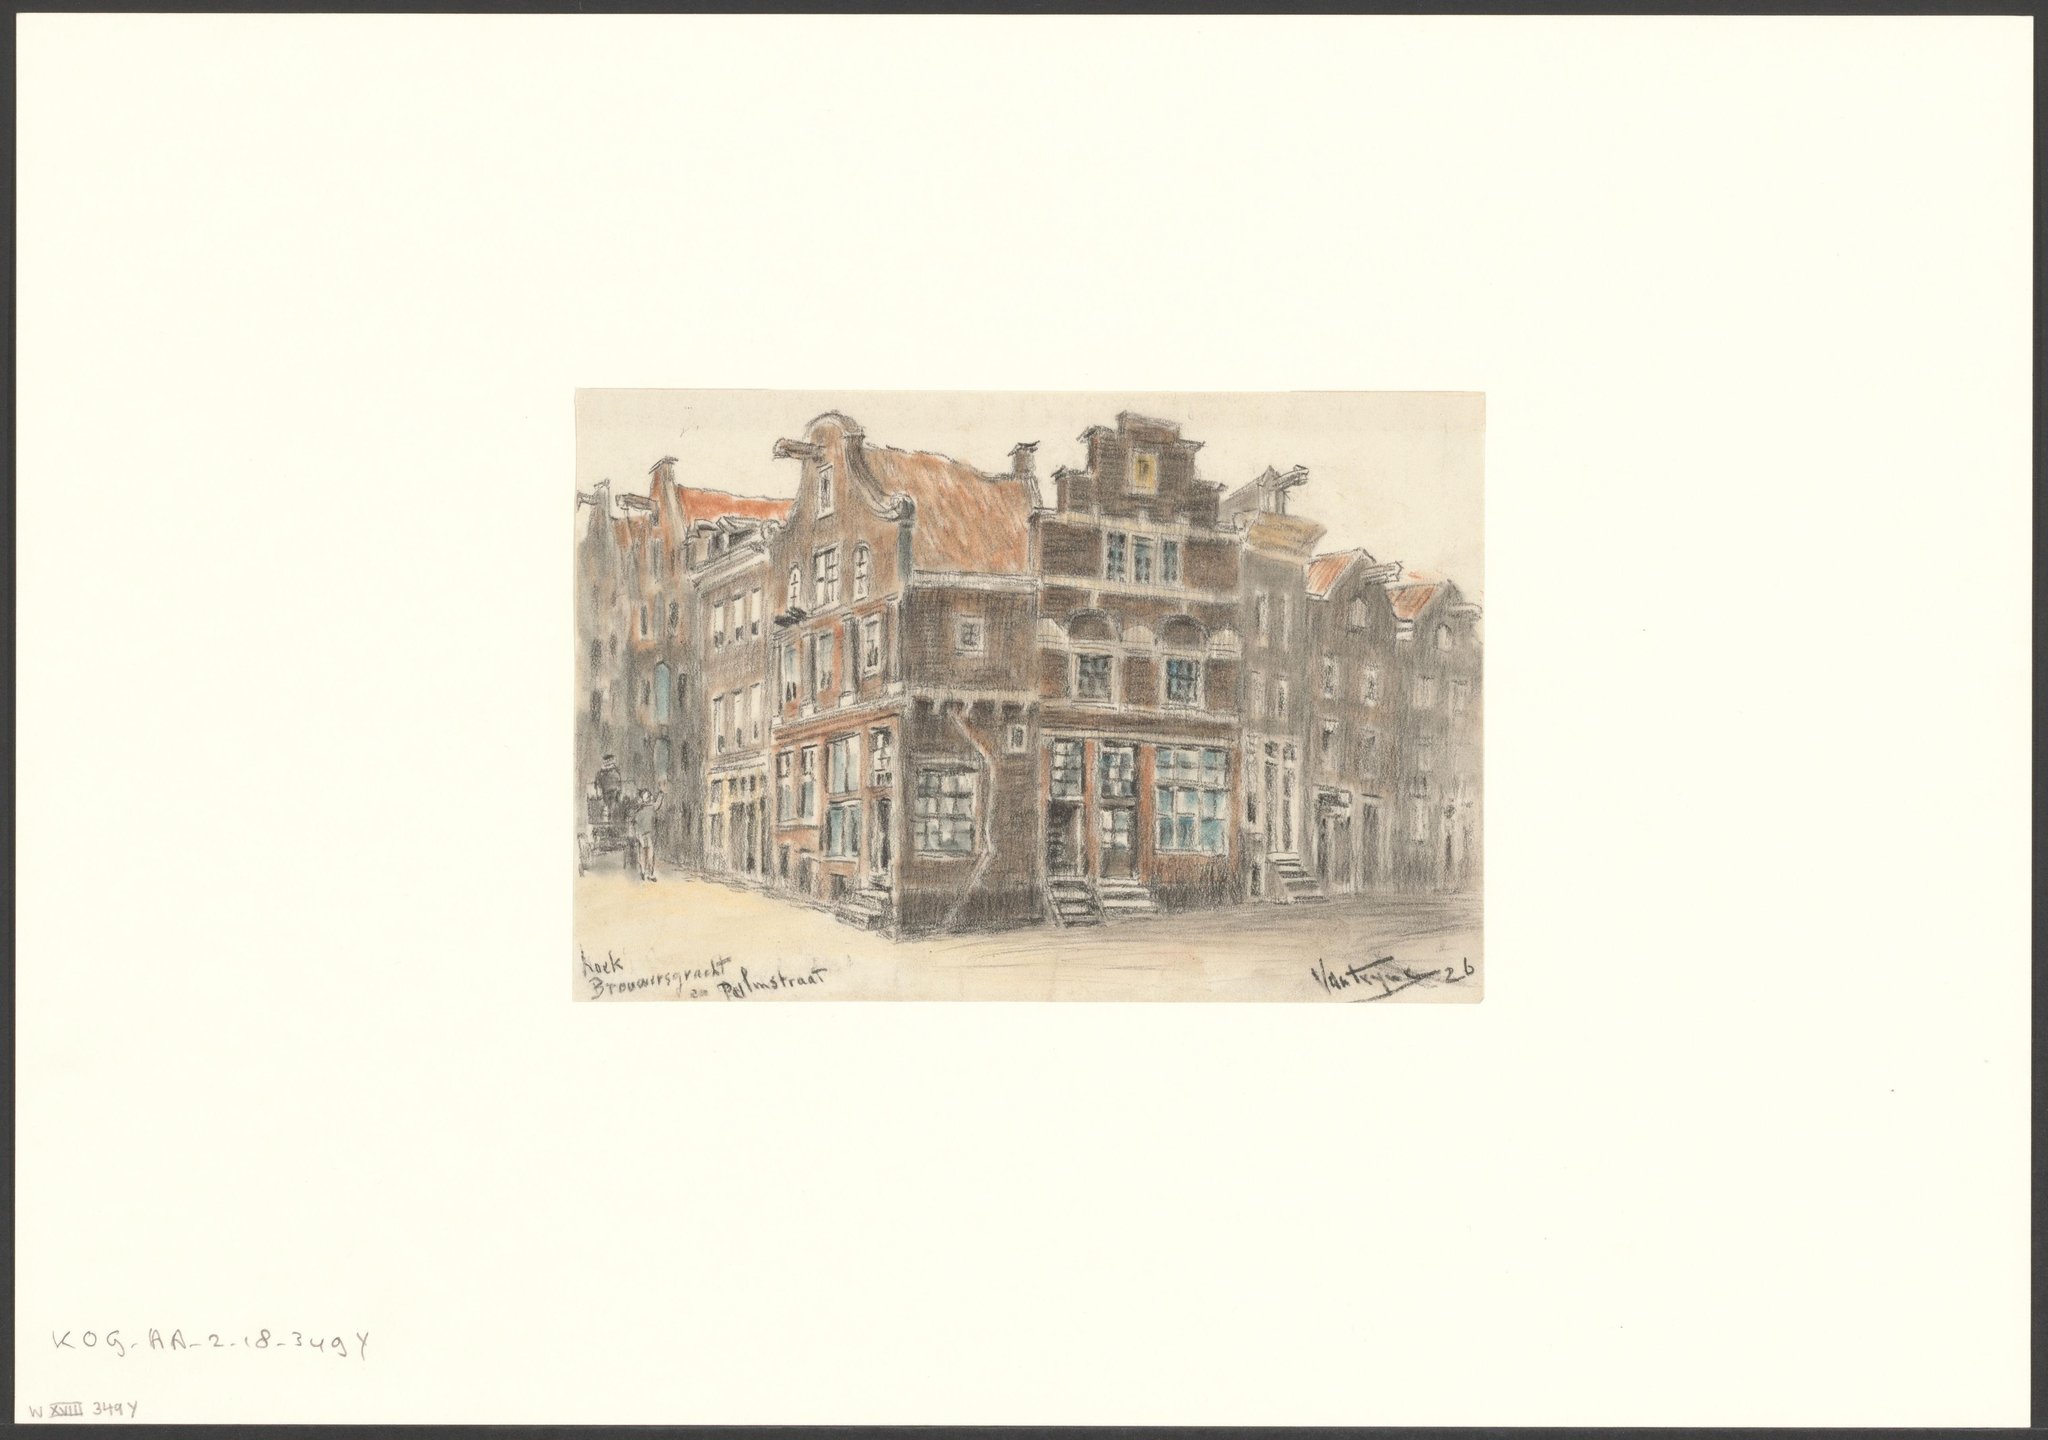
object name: drawing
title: Gezicht op de Brouwersgracht, hoek Palmstraat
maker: anthonie van teijn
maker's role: draughtsman, painter, print maker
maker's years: 1863-1943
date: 1926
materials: chalk, paper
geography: amsterdam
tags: city-view in general; 'veduta', façade (of house or building), street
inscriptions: stamp: ‘J. van Eck.’, signature and date: ‘VanTeyne 26’, inscription: ‘hoek / Brouwersgracht / en Palmstraat’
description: Tekening binnen de Atlas Van Eck ingedeeld op wijknummer 18.